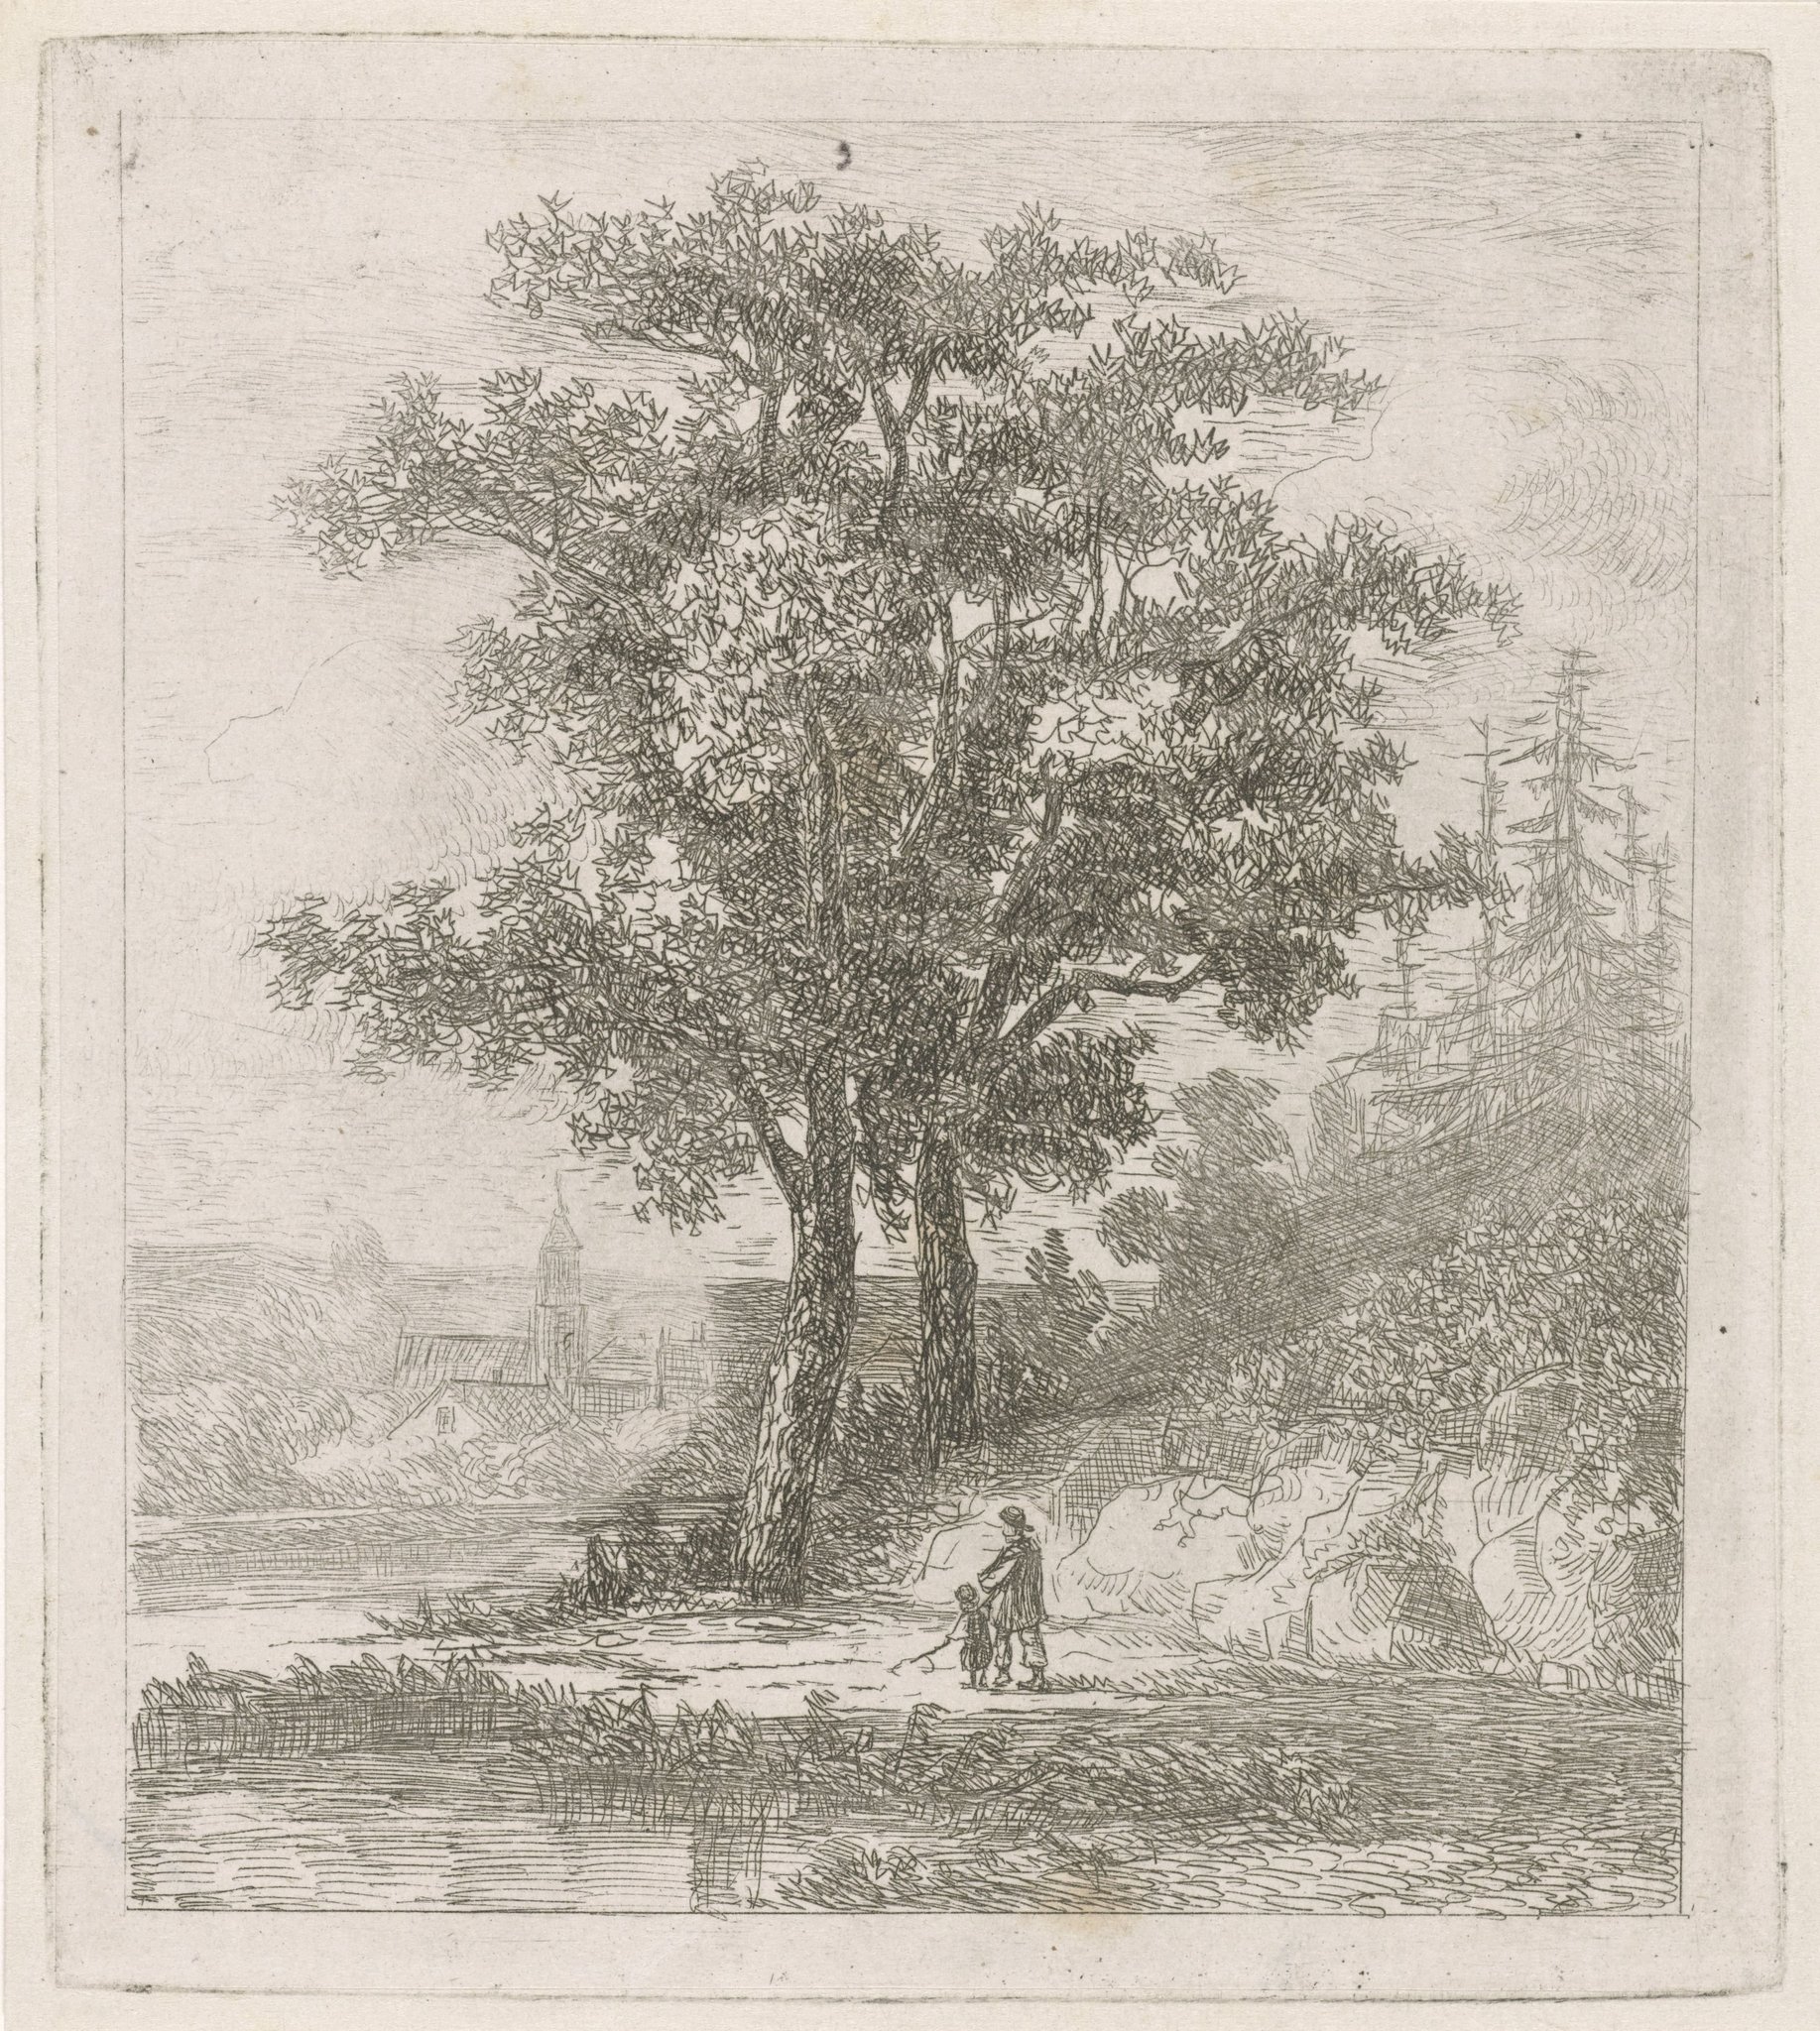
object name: print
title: Een man en een kind aan de waterkant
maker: hermanus jan hendrik van rijkelijkhuysen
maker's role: painter, print maker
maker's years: 1813-1883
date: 1823-1883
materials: paper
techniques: etching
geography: utrecht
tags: prospect of village, silhouette of village, river, trees: fir, father and child(ren), man and child(ren) (family group)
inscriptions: collector's mark: Lugt 2228, collector's mark: Lugt 1485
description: Aan de rand van een rivier lopen een man en een kind. Rechts een heuvel met sparren en op de achtergrond een dorp.